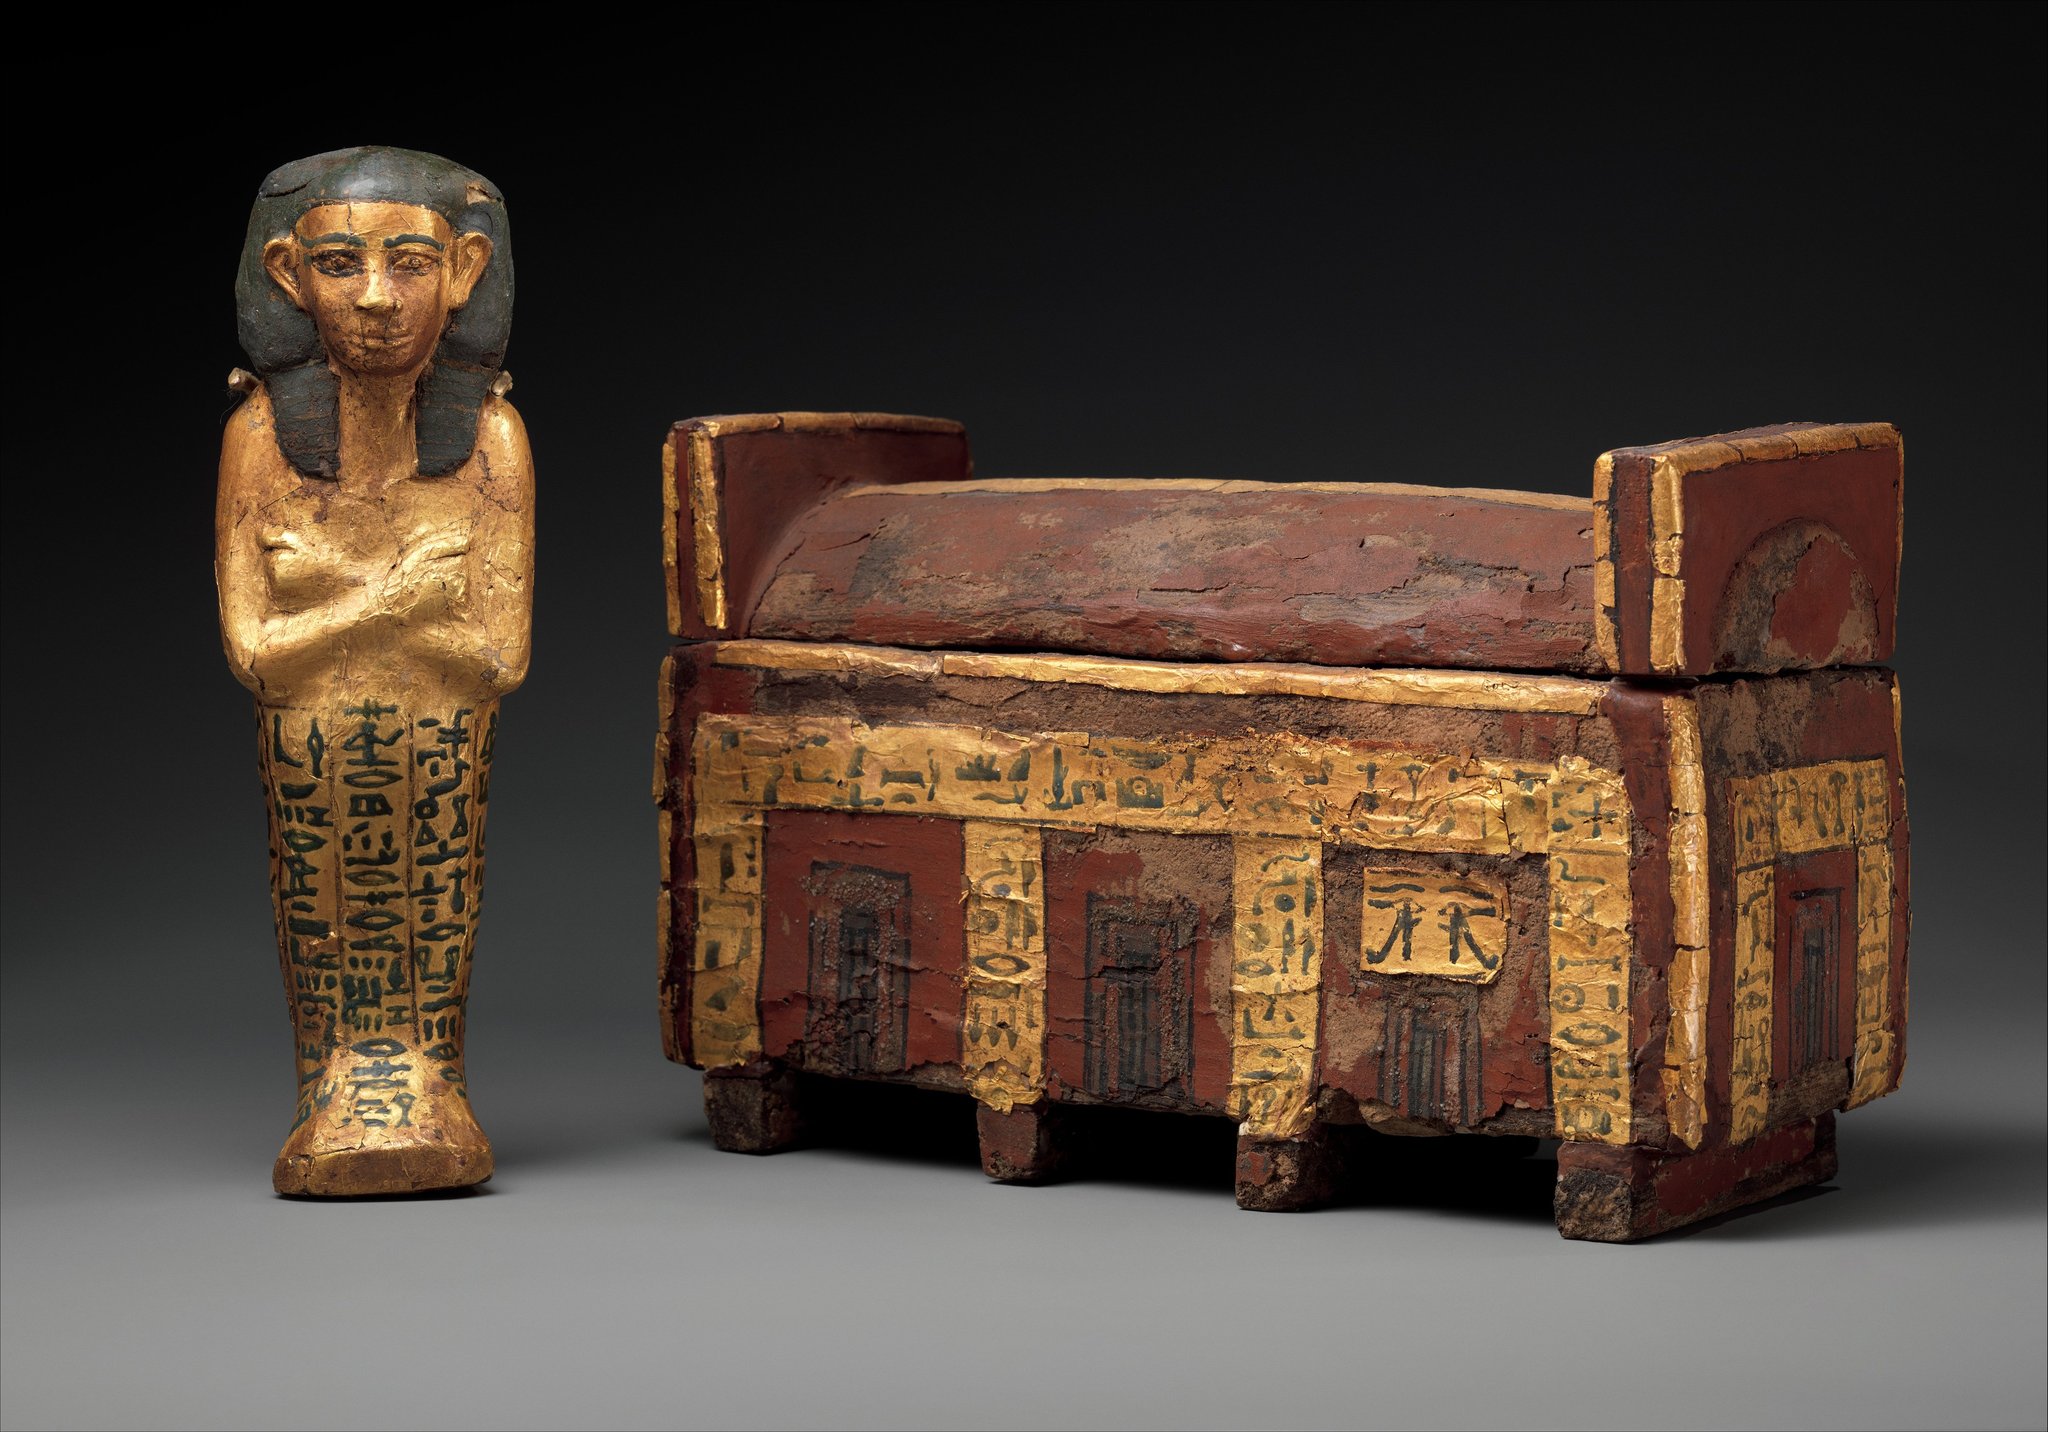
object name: shabti coffin, wahneferhotep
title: Shabti and Coffin of the King's Son Wahneferhotep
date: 1981-1640 BCE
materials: gold leaf, paint, wood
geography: egypt